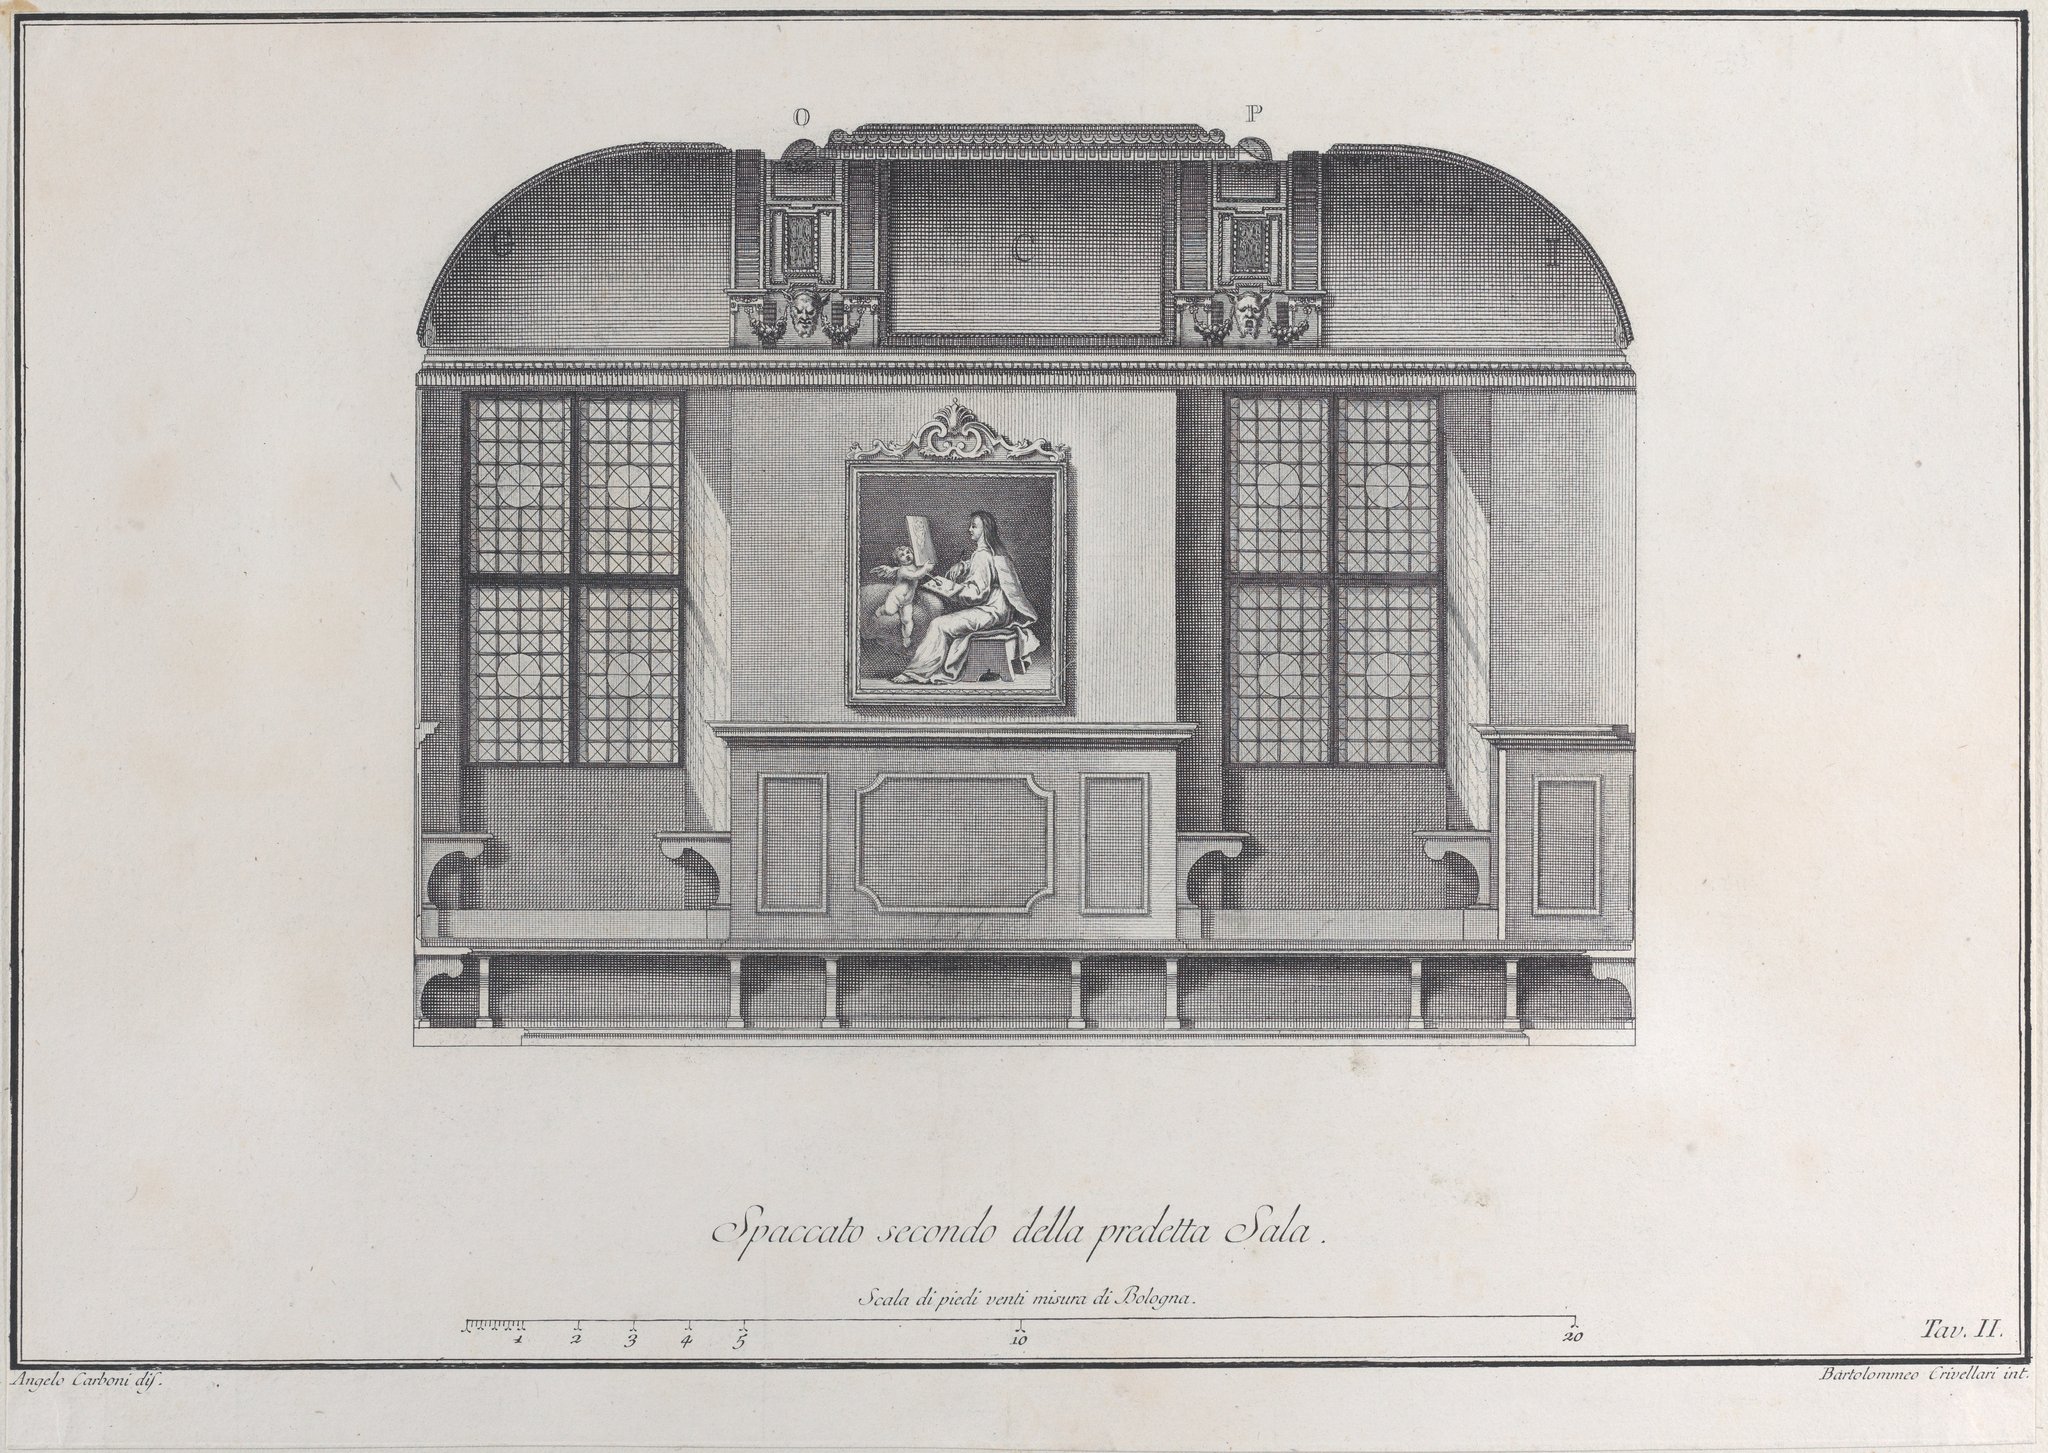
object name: print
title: Plate 2: cross-section of the Hall of the Institute of Bologna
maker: bartolomeo crivellari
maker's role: artist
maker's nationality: italian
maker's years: 1700-1800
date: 1756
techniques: etching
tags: architecture,buildings